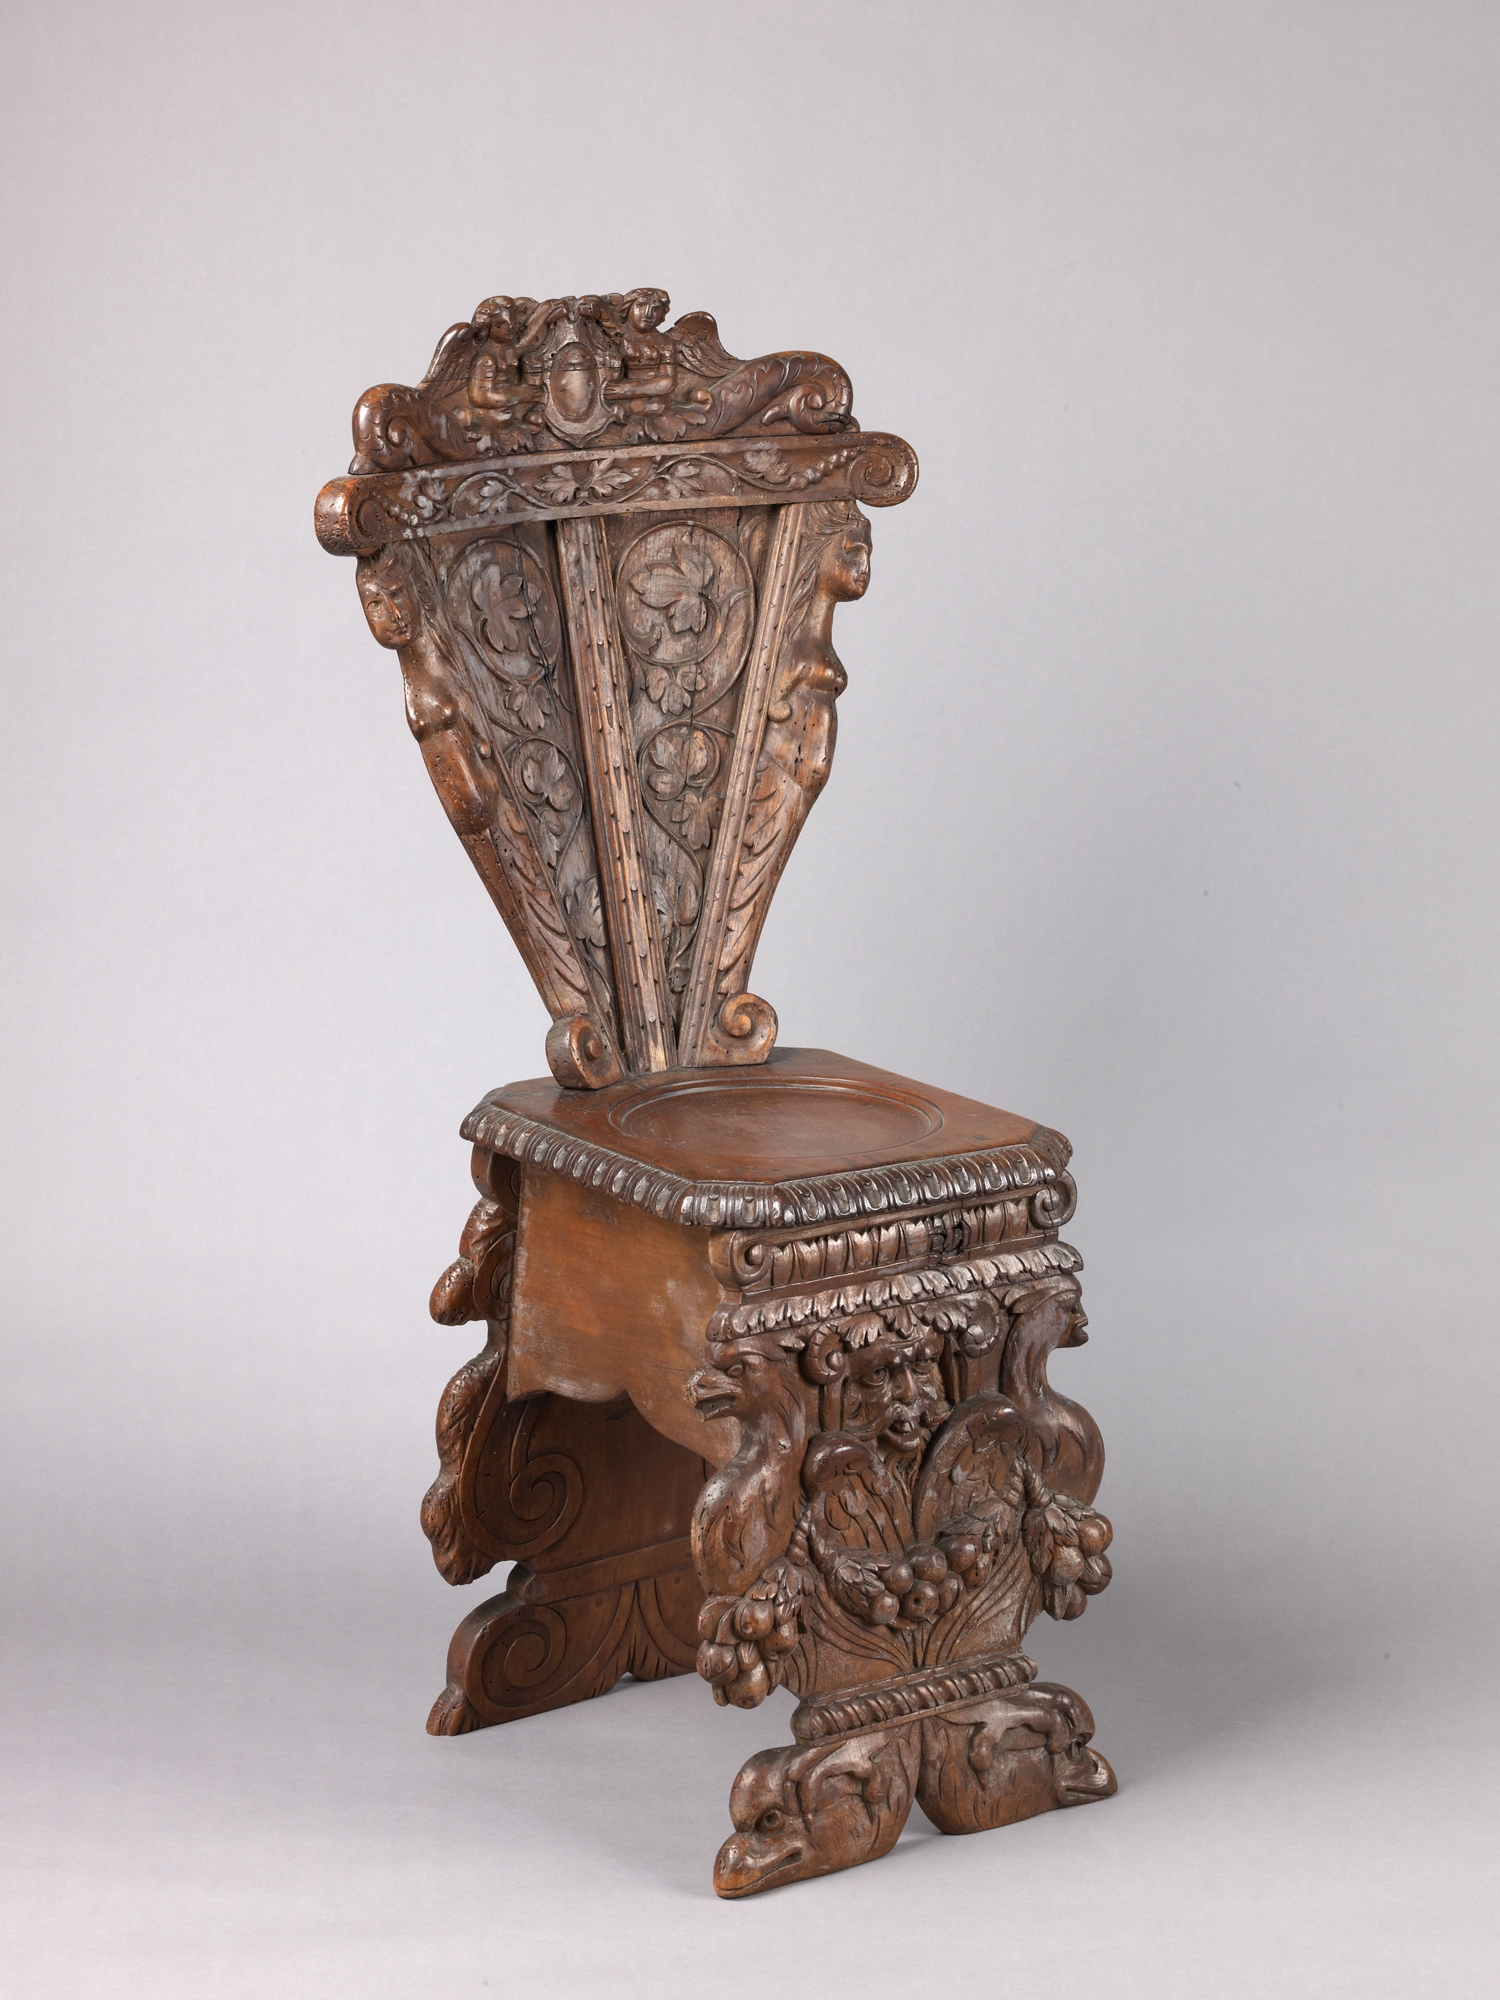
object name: chair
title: Side chair (sgabello a dorsale)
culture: italian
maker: alois überacher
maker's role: artist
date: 1867-1900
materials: wood